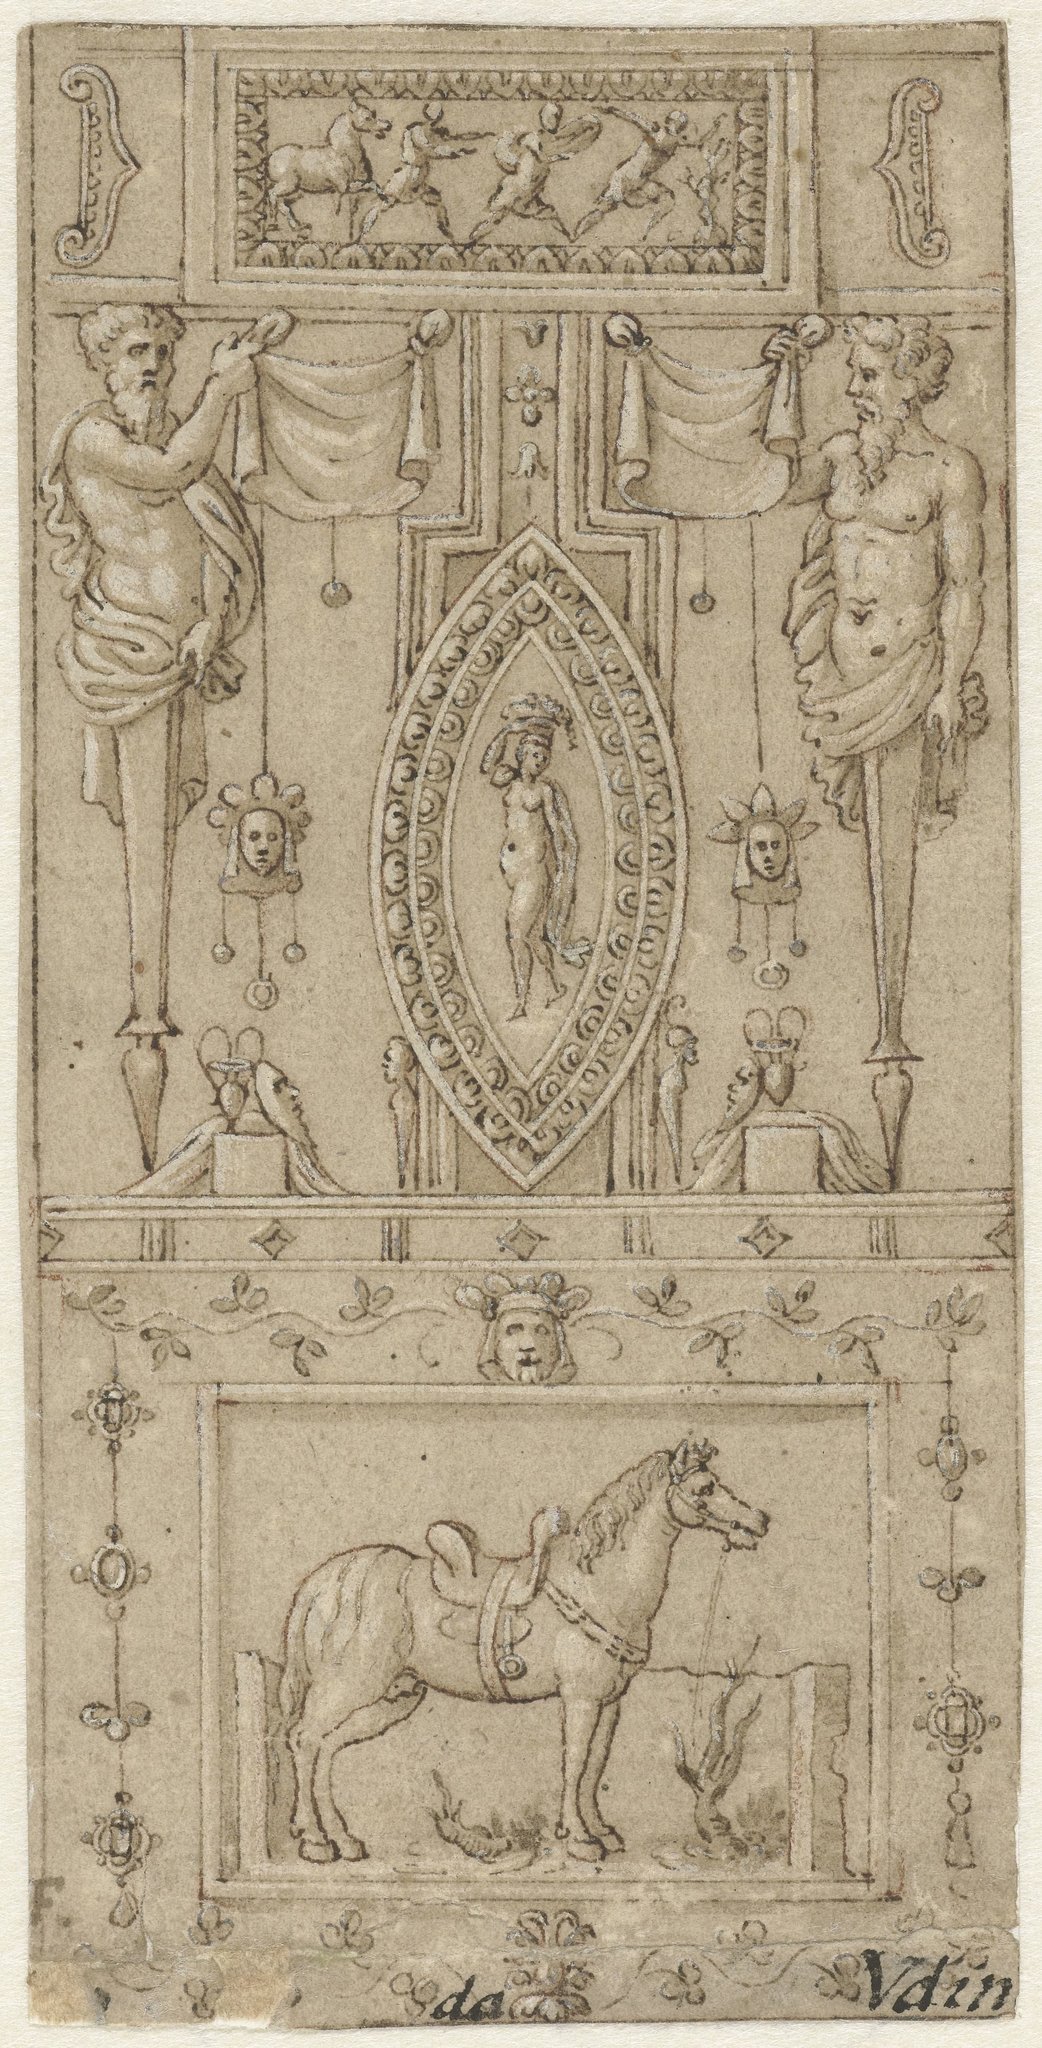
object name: drawing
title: Decoratieve paneelvulling uit de Loggiën van het Vaticaan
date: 1510-1600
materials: ink, paper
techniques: brush, pen